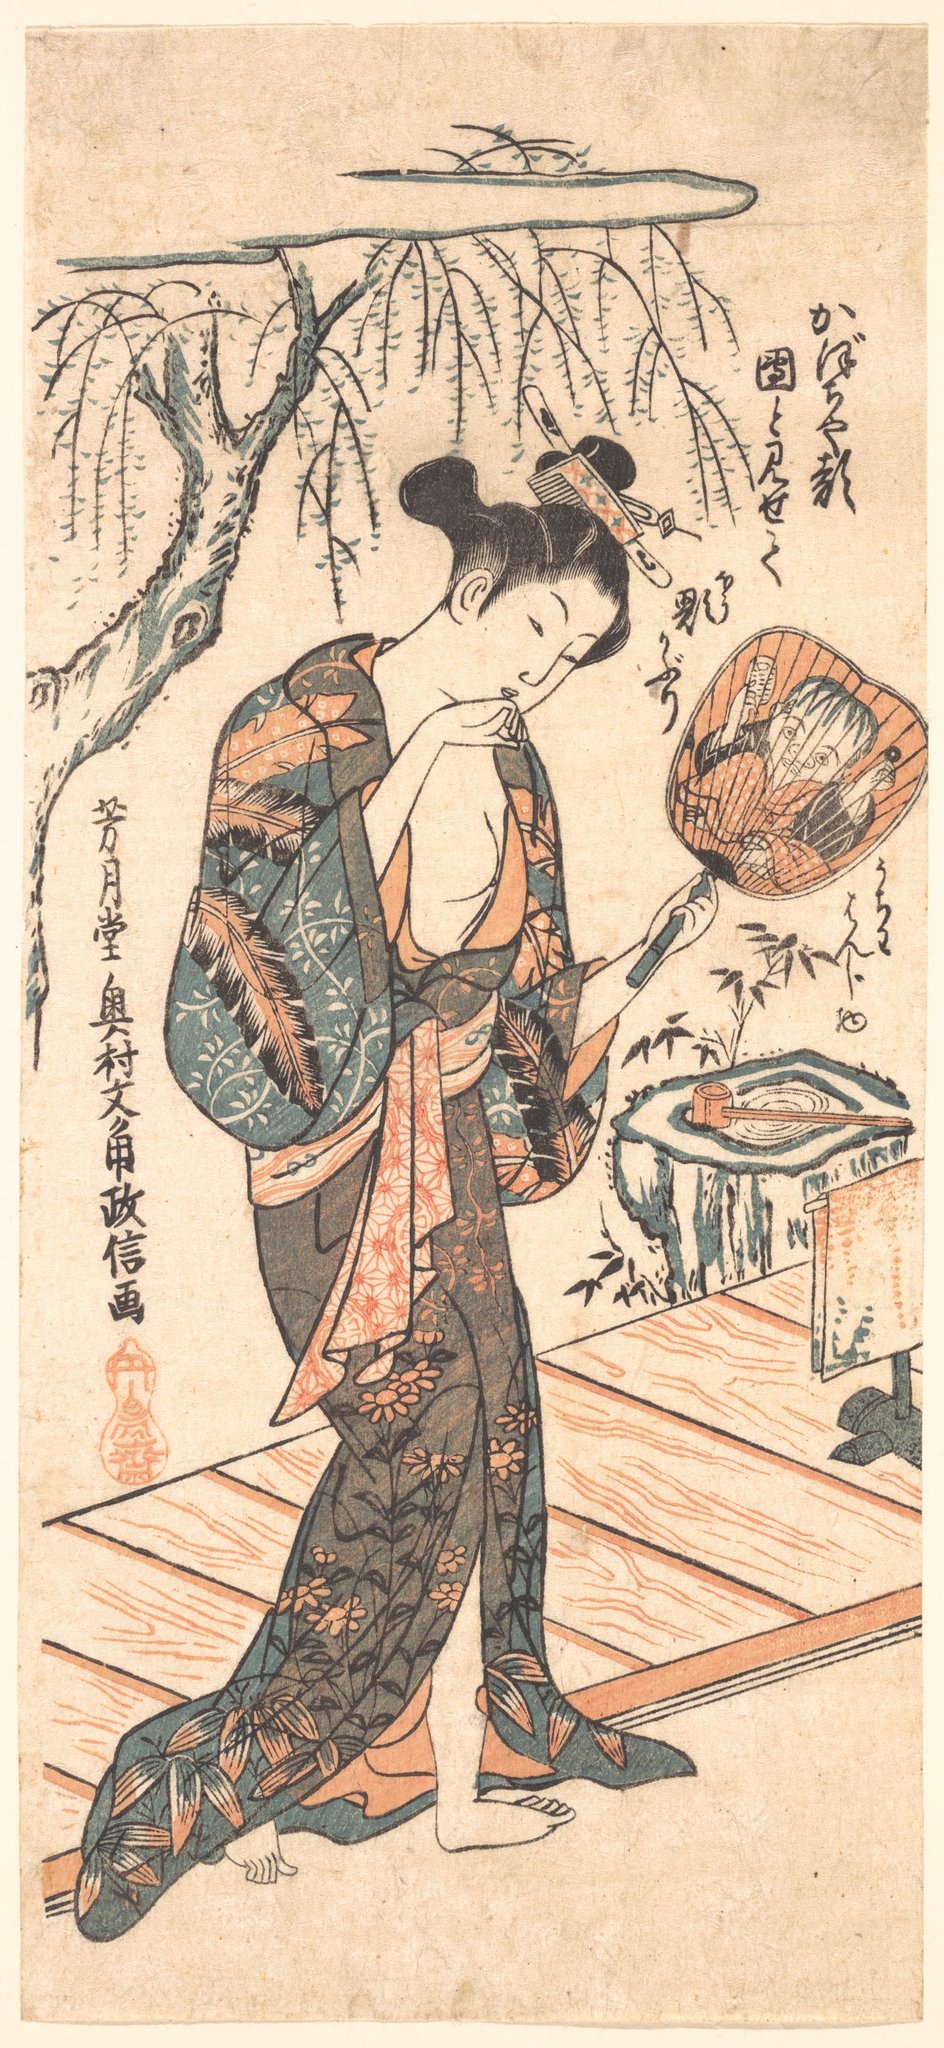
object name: print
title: Woman In Loosened Kimono Coming From the Bath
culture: japanese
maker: okumura masanobu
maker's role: artist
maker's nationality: japanese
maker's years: 1686-1764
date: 1755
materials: ink, paper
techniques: woodblock print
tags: fans,women,trees